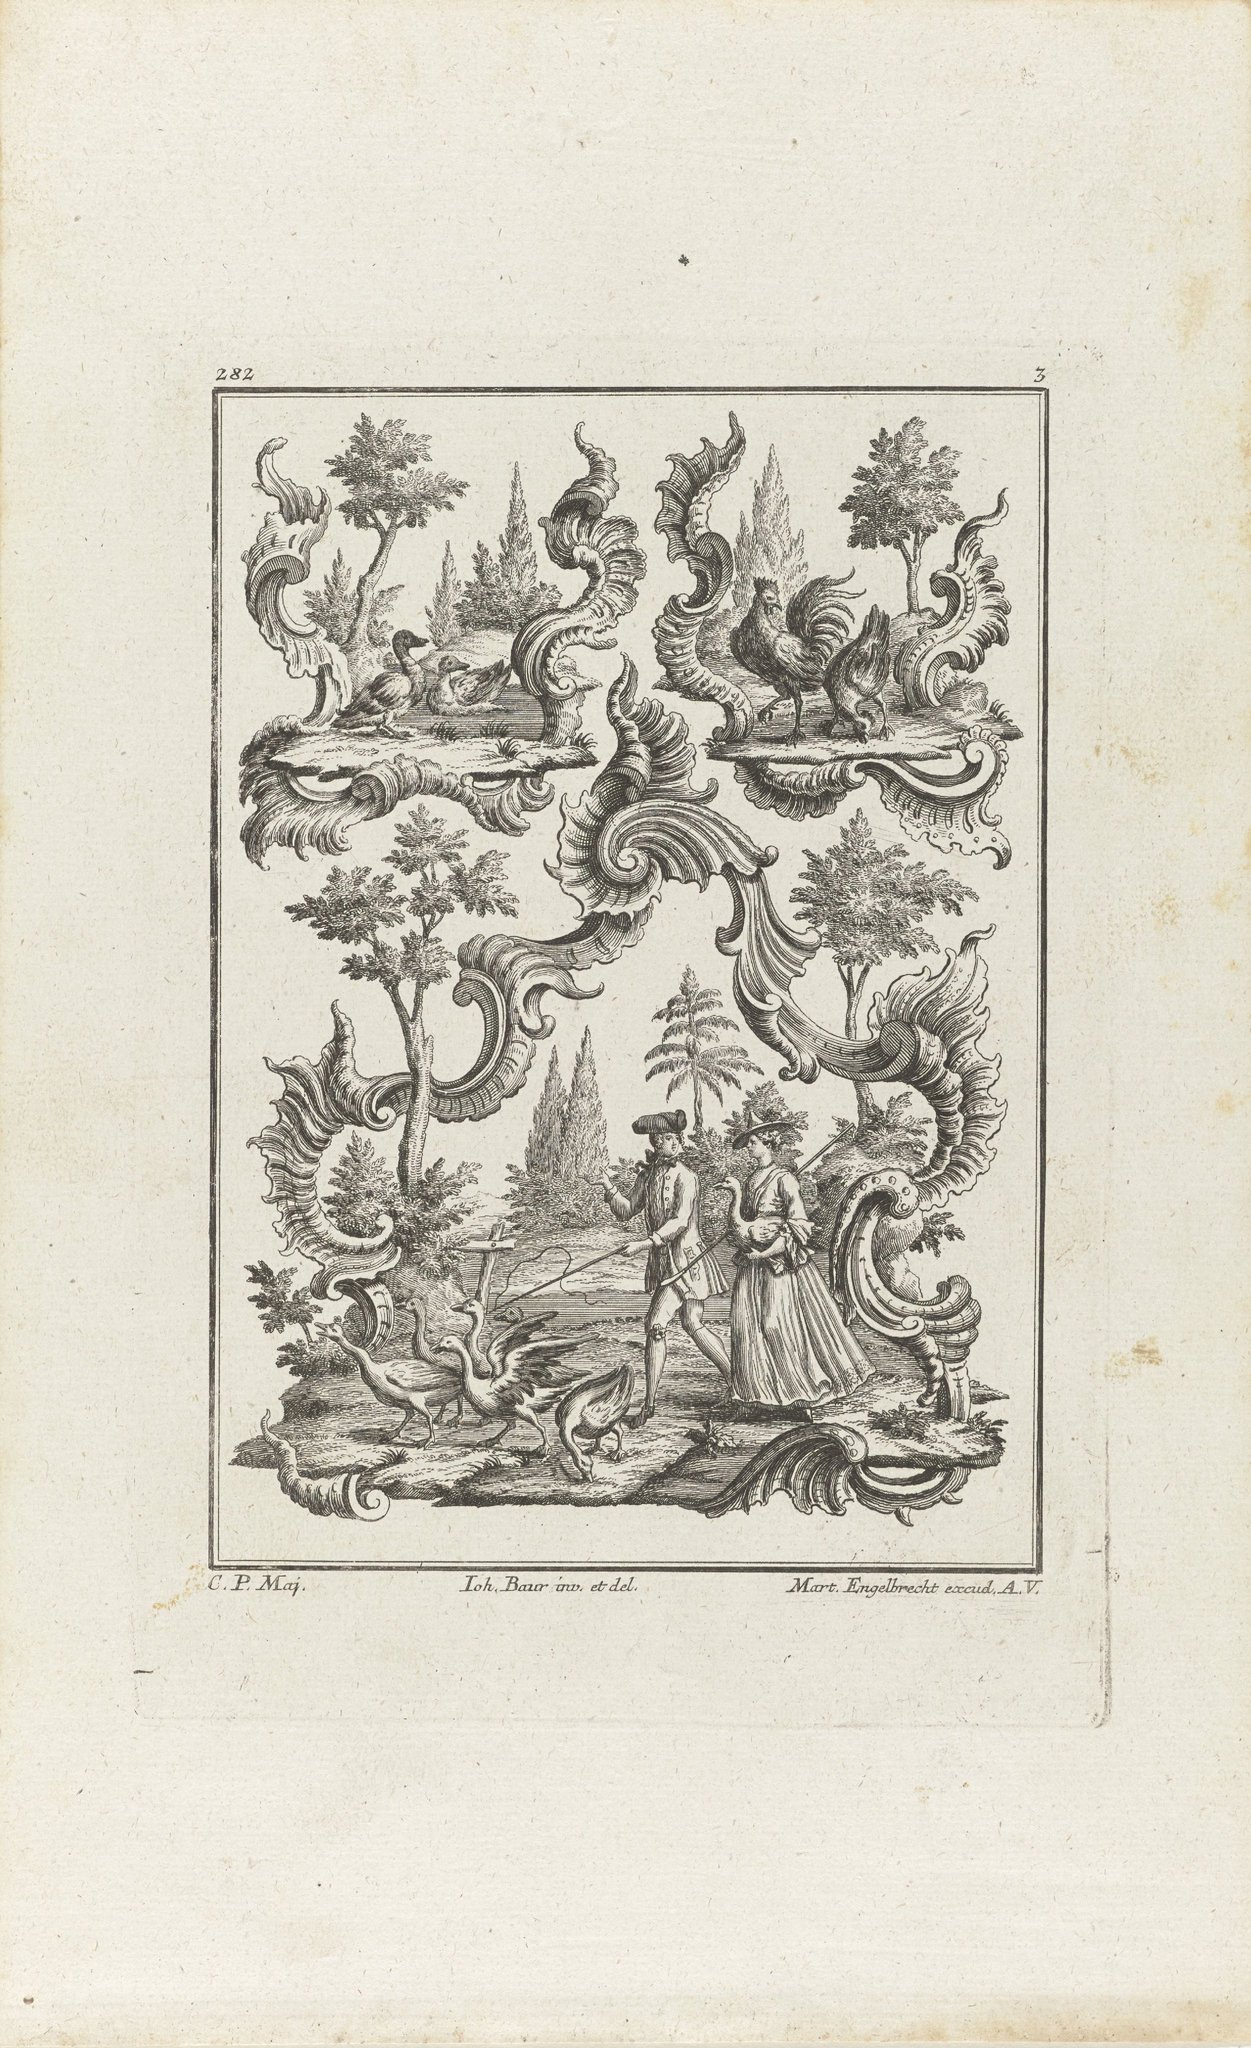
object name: print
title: Pastorale scènes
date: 1719-1749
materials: paper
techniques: etching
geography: augsburg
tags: rocaille ornament, water-birds: goose, herding, herdsman, herdswoman, shepherd, shepherdess, cowherd, etc., fowl (cock, hen, chicken, etc.), pastorals, arcadian scenes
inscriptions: collector's mark: Lugt 2228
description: Drie rocailles met voorstellingen. Onder een landschap met een ganzenhoedend paar. In de bovenste twee rocailles pluimvee; links eenden en rechts kippen. Linksboven 282 genummerd.